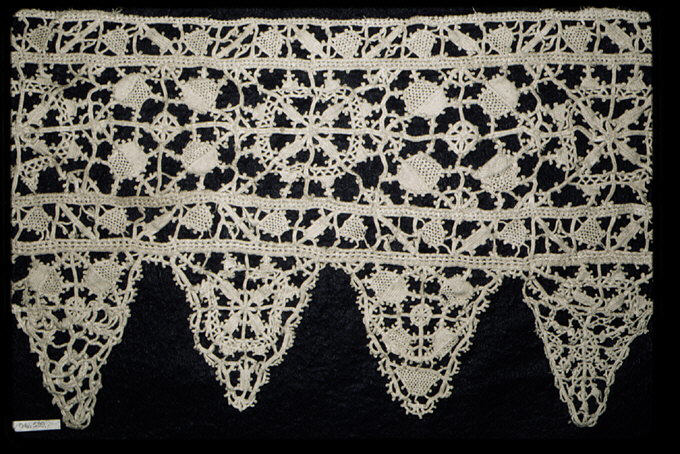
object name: border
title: Lace border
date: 1601-1633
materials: linen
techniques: lace